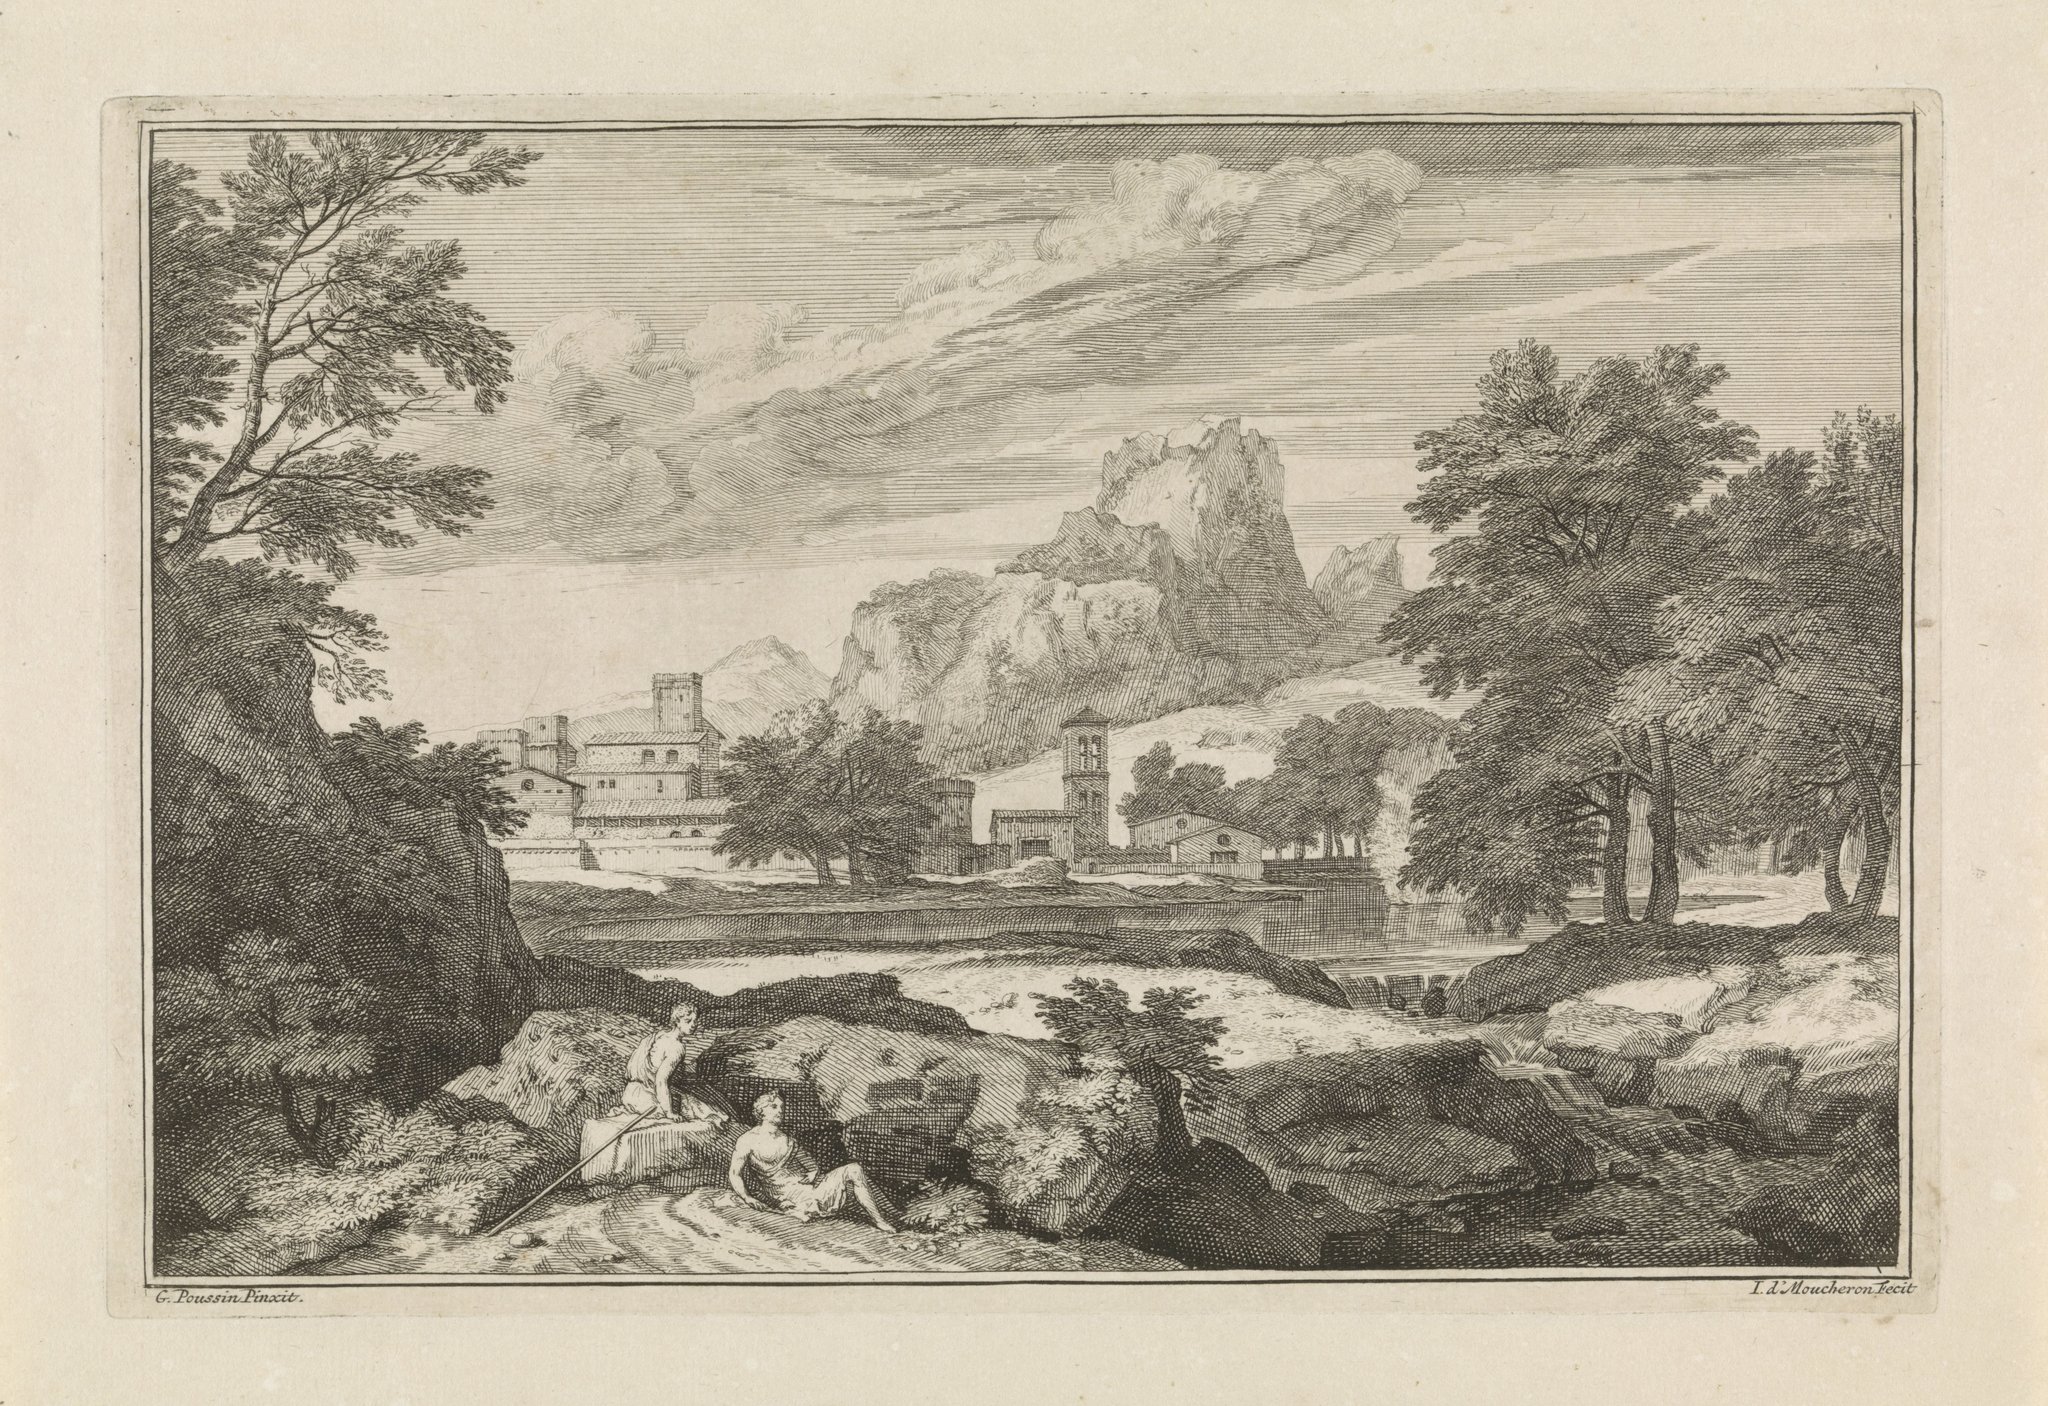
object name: print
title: Landschap met twee rustende figuren op de voorgrond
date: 1697-1744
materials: paper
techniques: engraving, etching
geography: rome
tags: waterfall, pastorals, arcadian scenes, lake (+ landscape with figures, staffage)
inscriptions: collector's mark: Lugt 240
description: Landschap met twee rustende figuren op de voorgrond. In het midden een meer uitmondend in een waterval. Op de achtergrond gebouwen en een hoge berg.